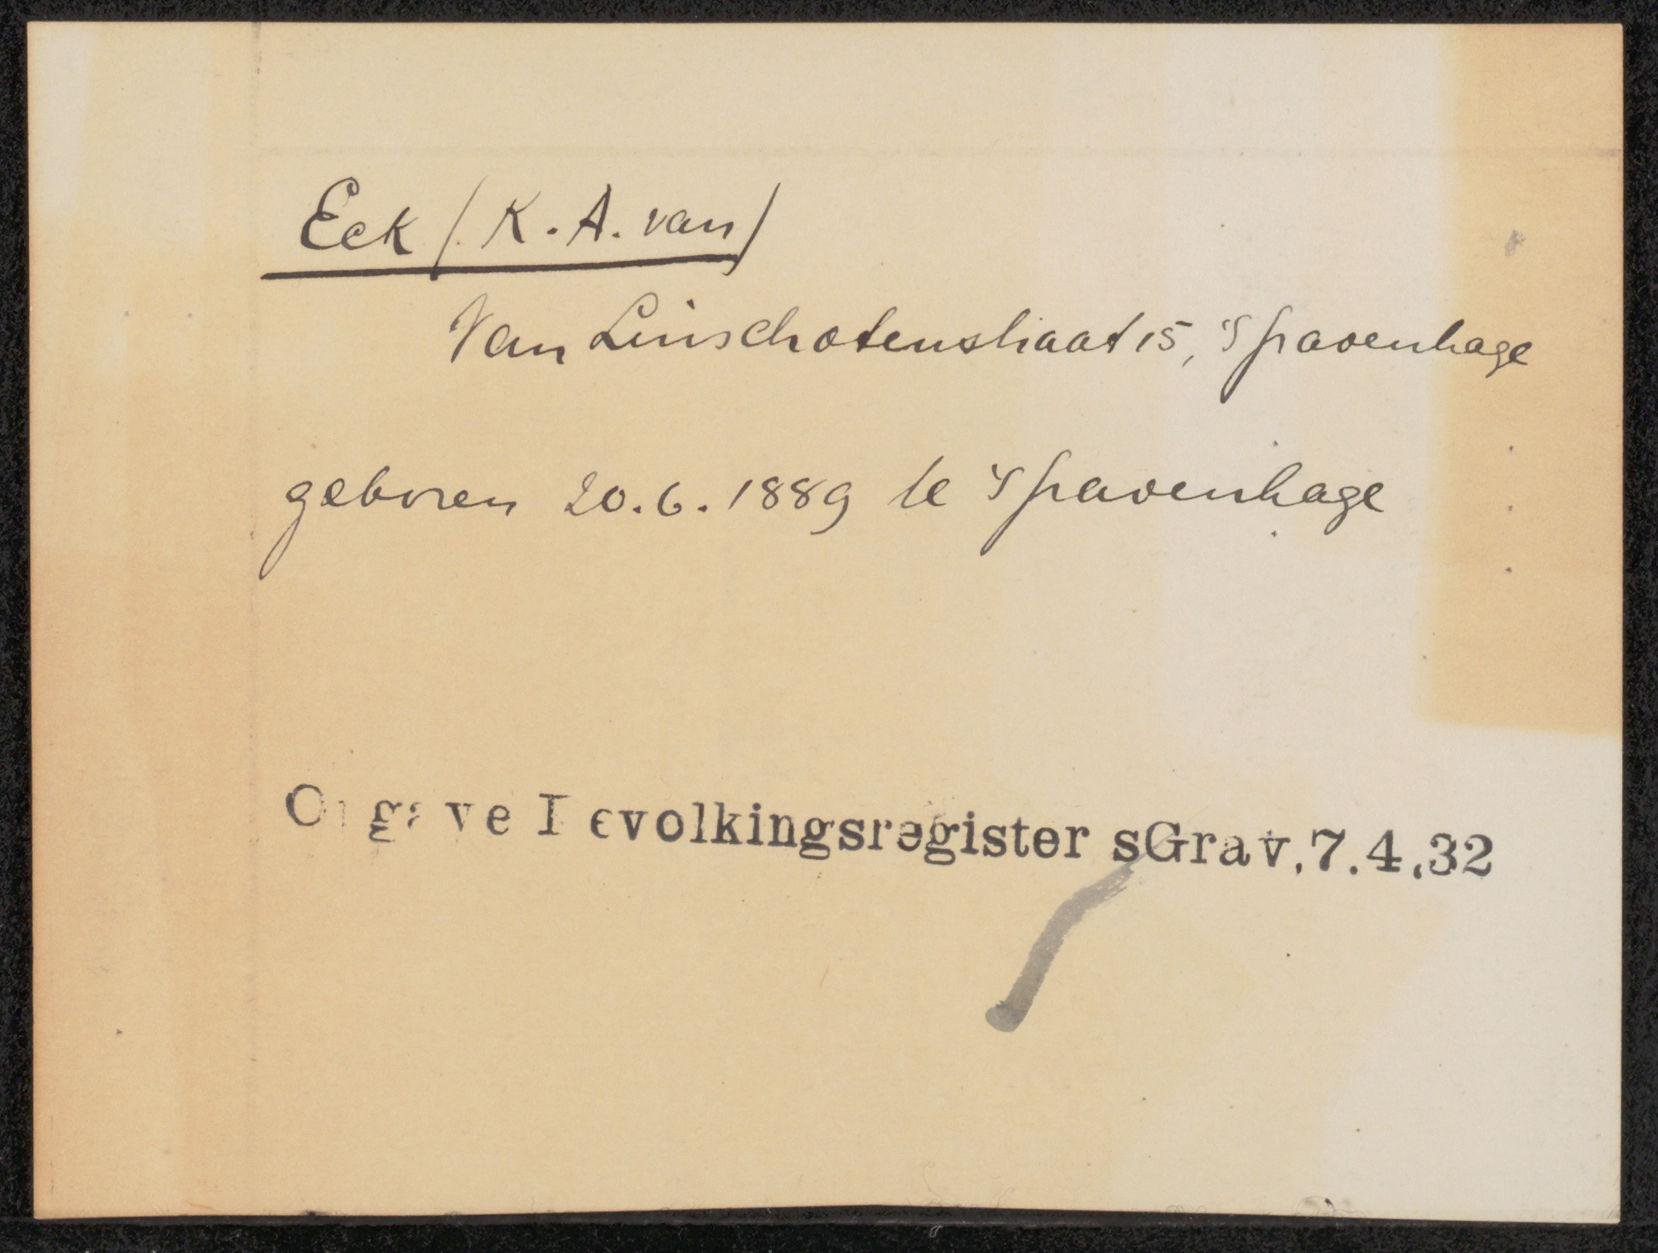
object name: document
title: Document betreffende Karel Anthonie van Eck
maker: Anonymous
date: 1932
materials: ink, paper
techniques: pen, writing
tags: the hague, print maker, karel anthonie van eck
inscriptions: stamp: ‘Opgave Bevolkingsregister sGrav. 7.4.32’